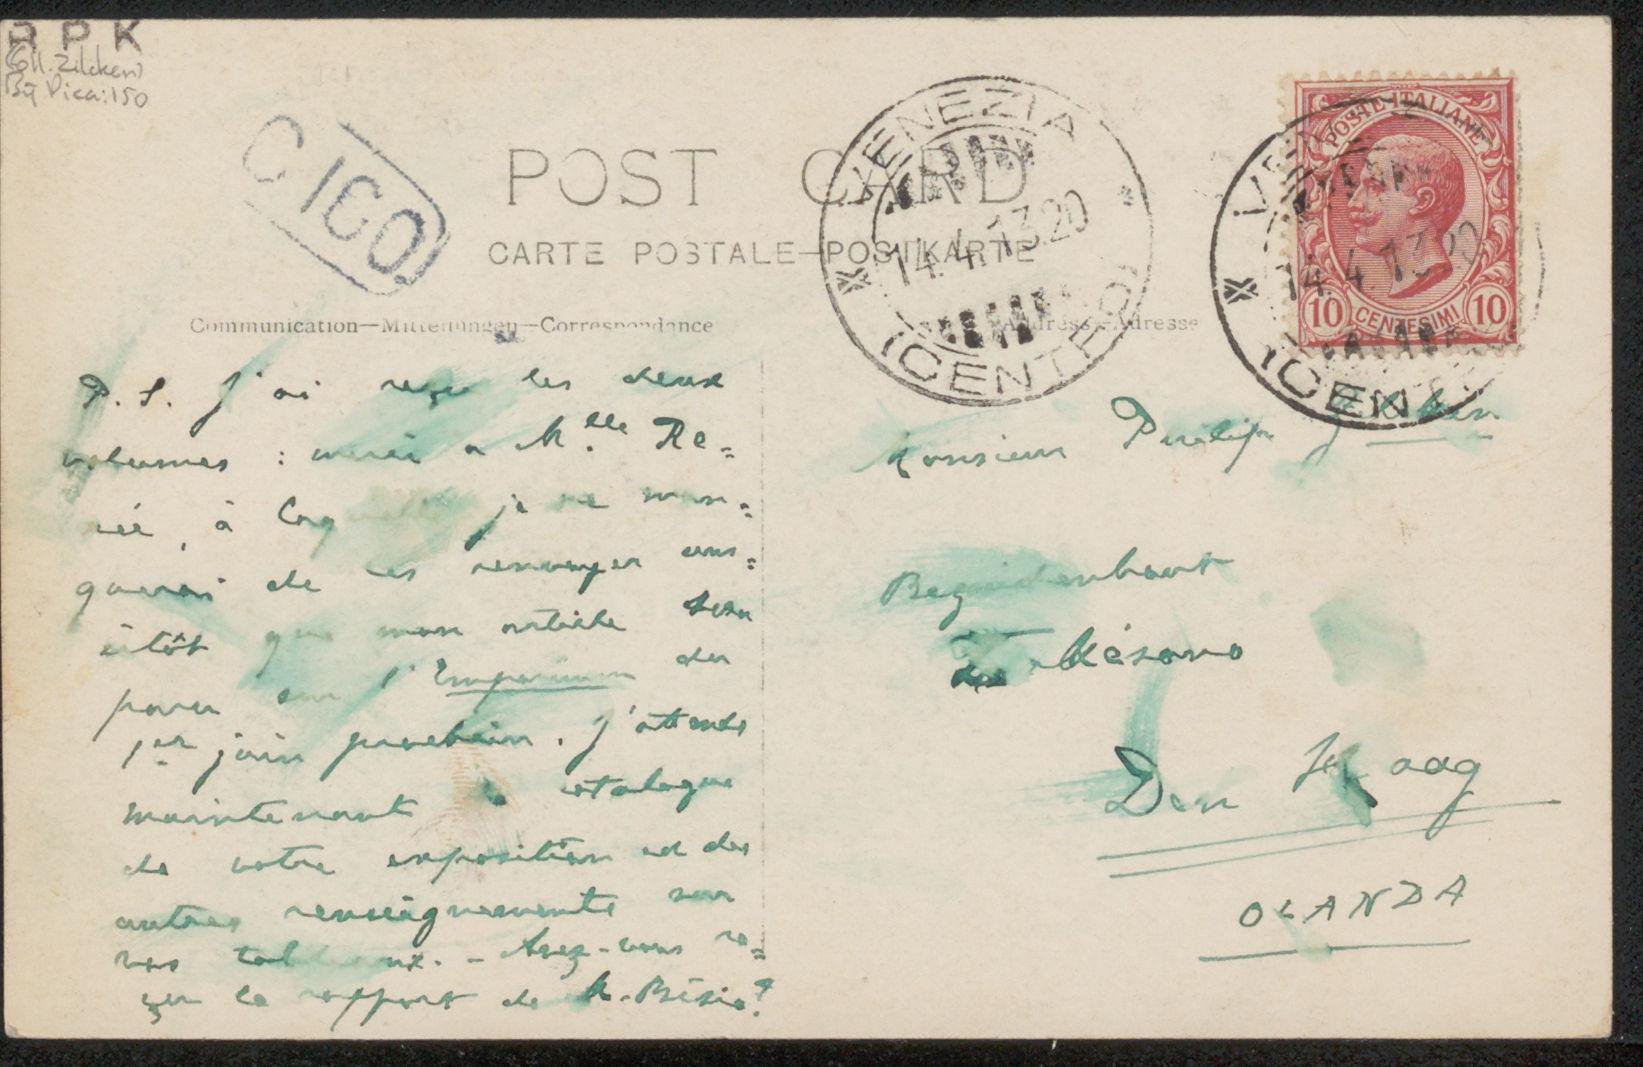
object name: ansichtkaart, prentbriefkaart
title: Prentbriefkaart aan Philip Zilcken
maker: vittorio pica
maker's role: criticus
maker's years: 1864-1930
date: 1913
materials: cardboard, ink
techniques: gelatin silver print, pen, writing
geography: venice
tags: leopoldo bizio gradenigo, painter, draughtsman, philip zilcken, painting (including book-illumination, miniature-painting), exhibition ~ art, printed matter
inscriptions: collector's mark: ‘RPK’